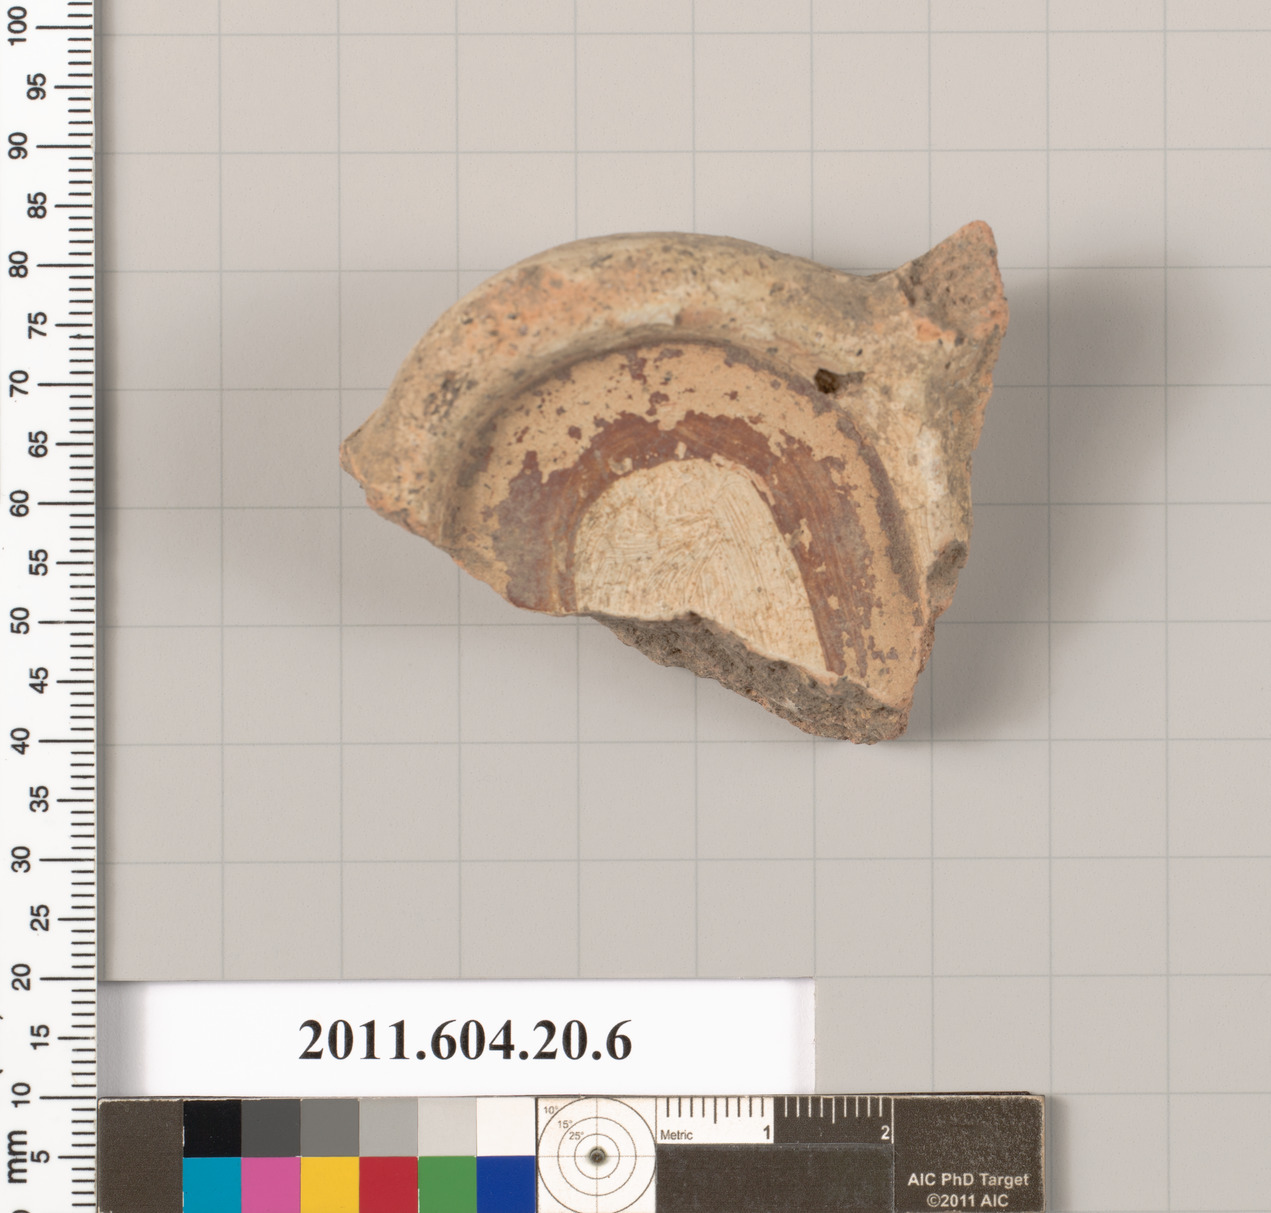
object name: architectural fragment, terracotta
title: Terracotta architectural fragment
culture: greek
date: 600-401 BCE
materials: terracotta